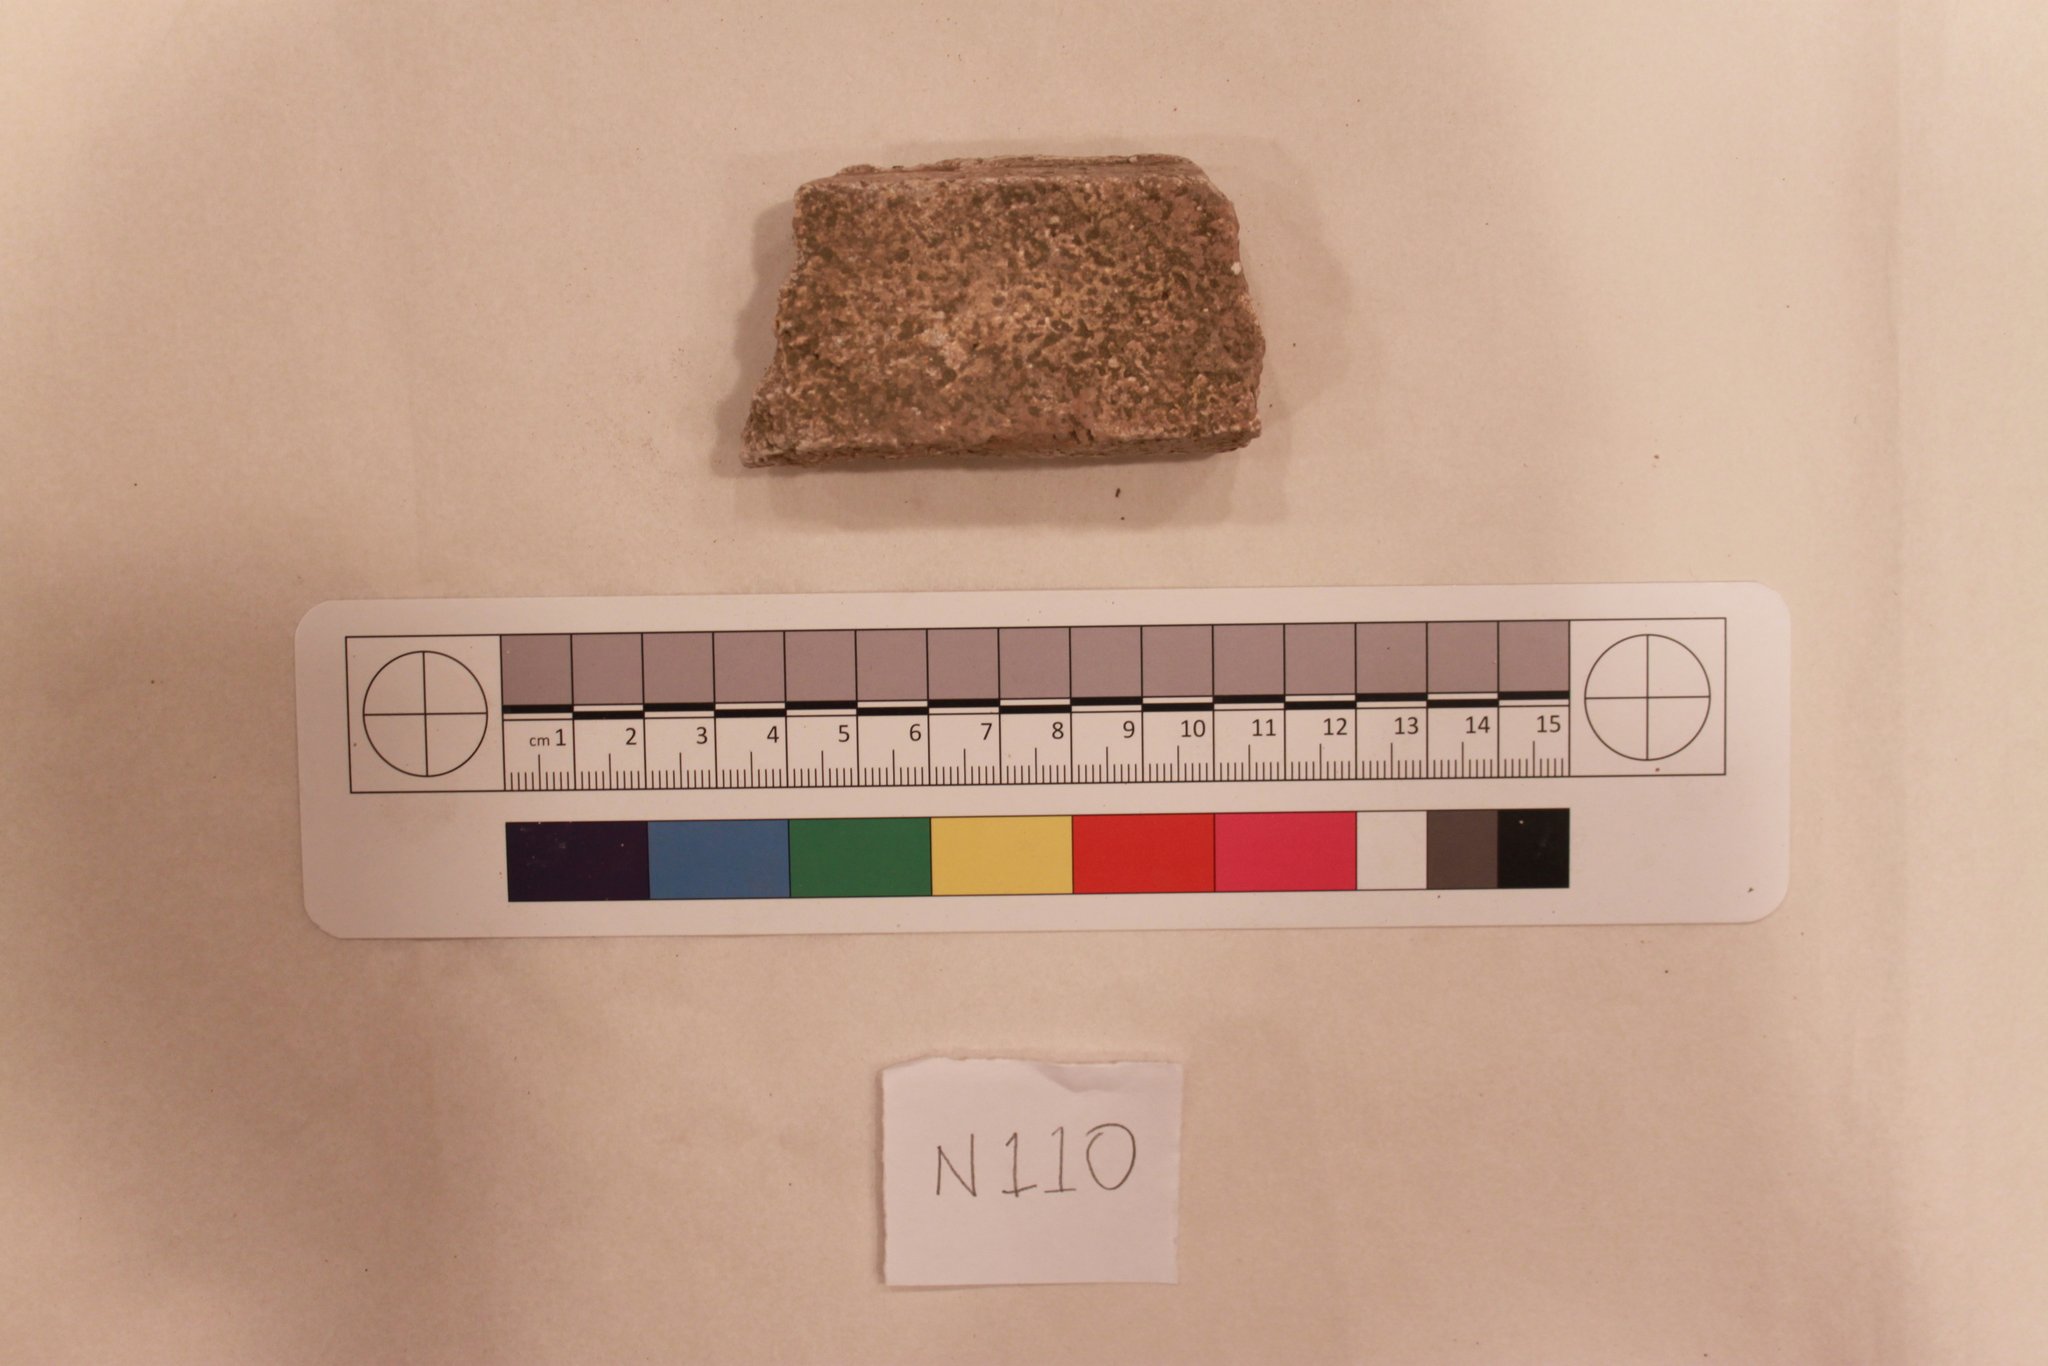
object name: fragment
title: Stucco Fragment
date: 701-1200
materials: plaster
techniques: carving, painting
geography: iran